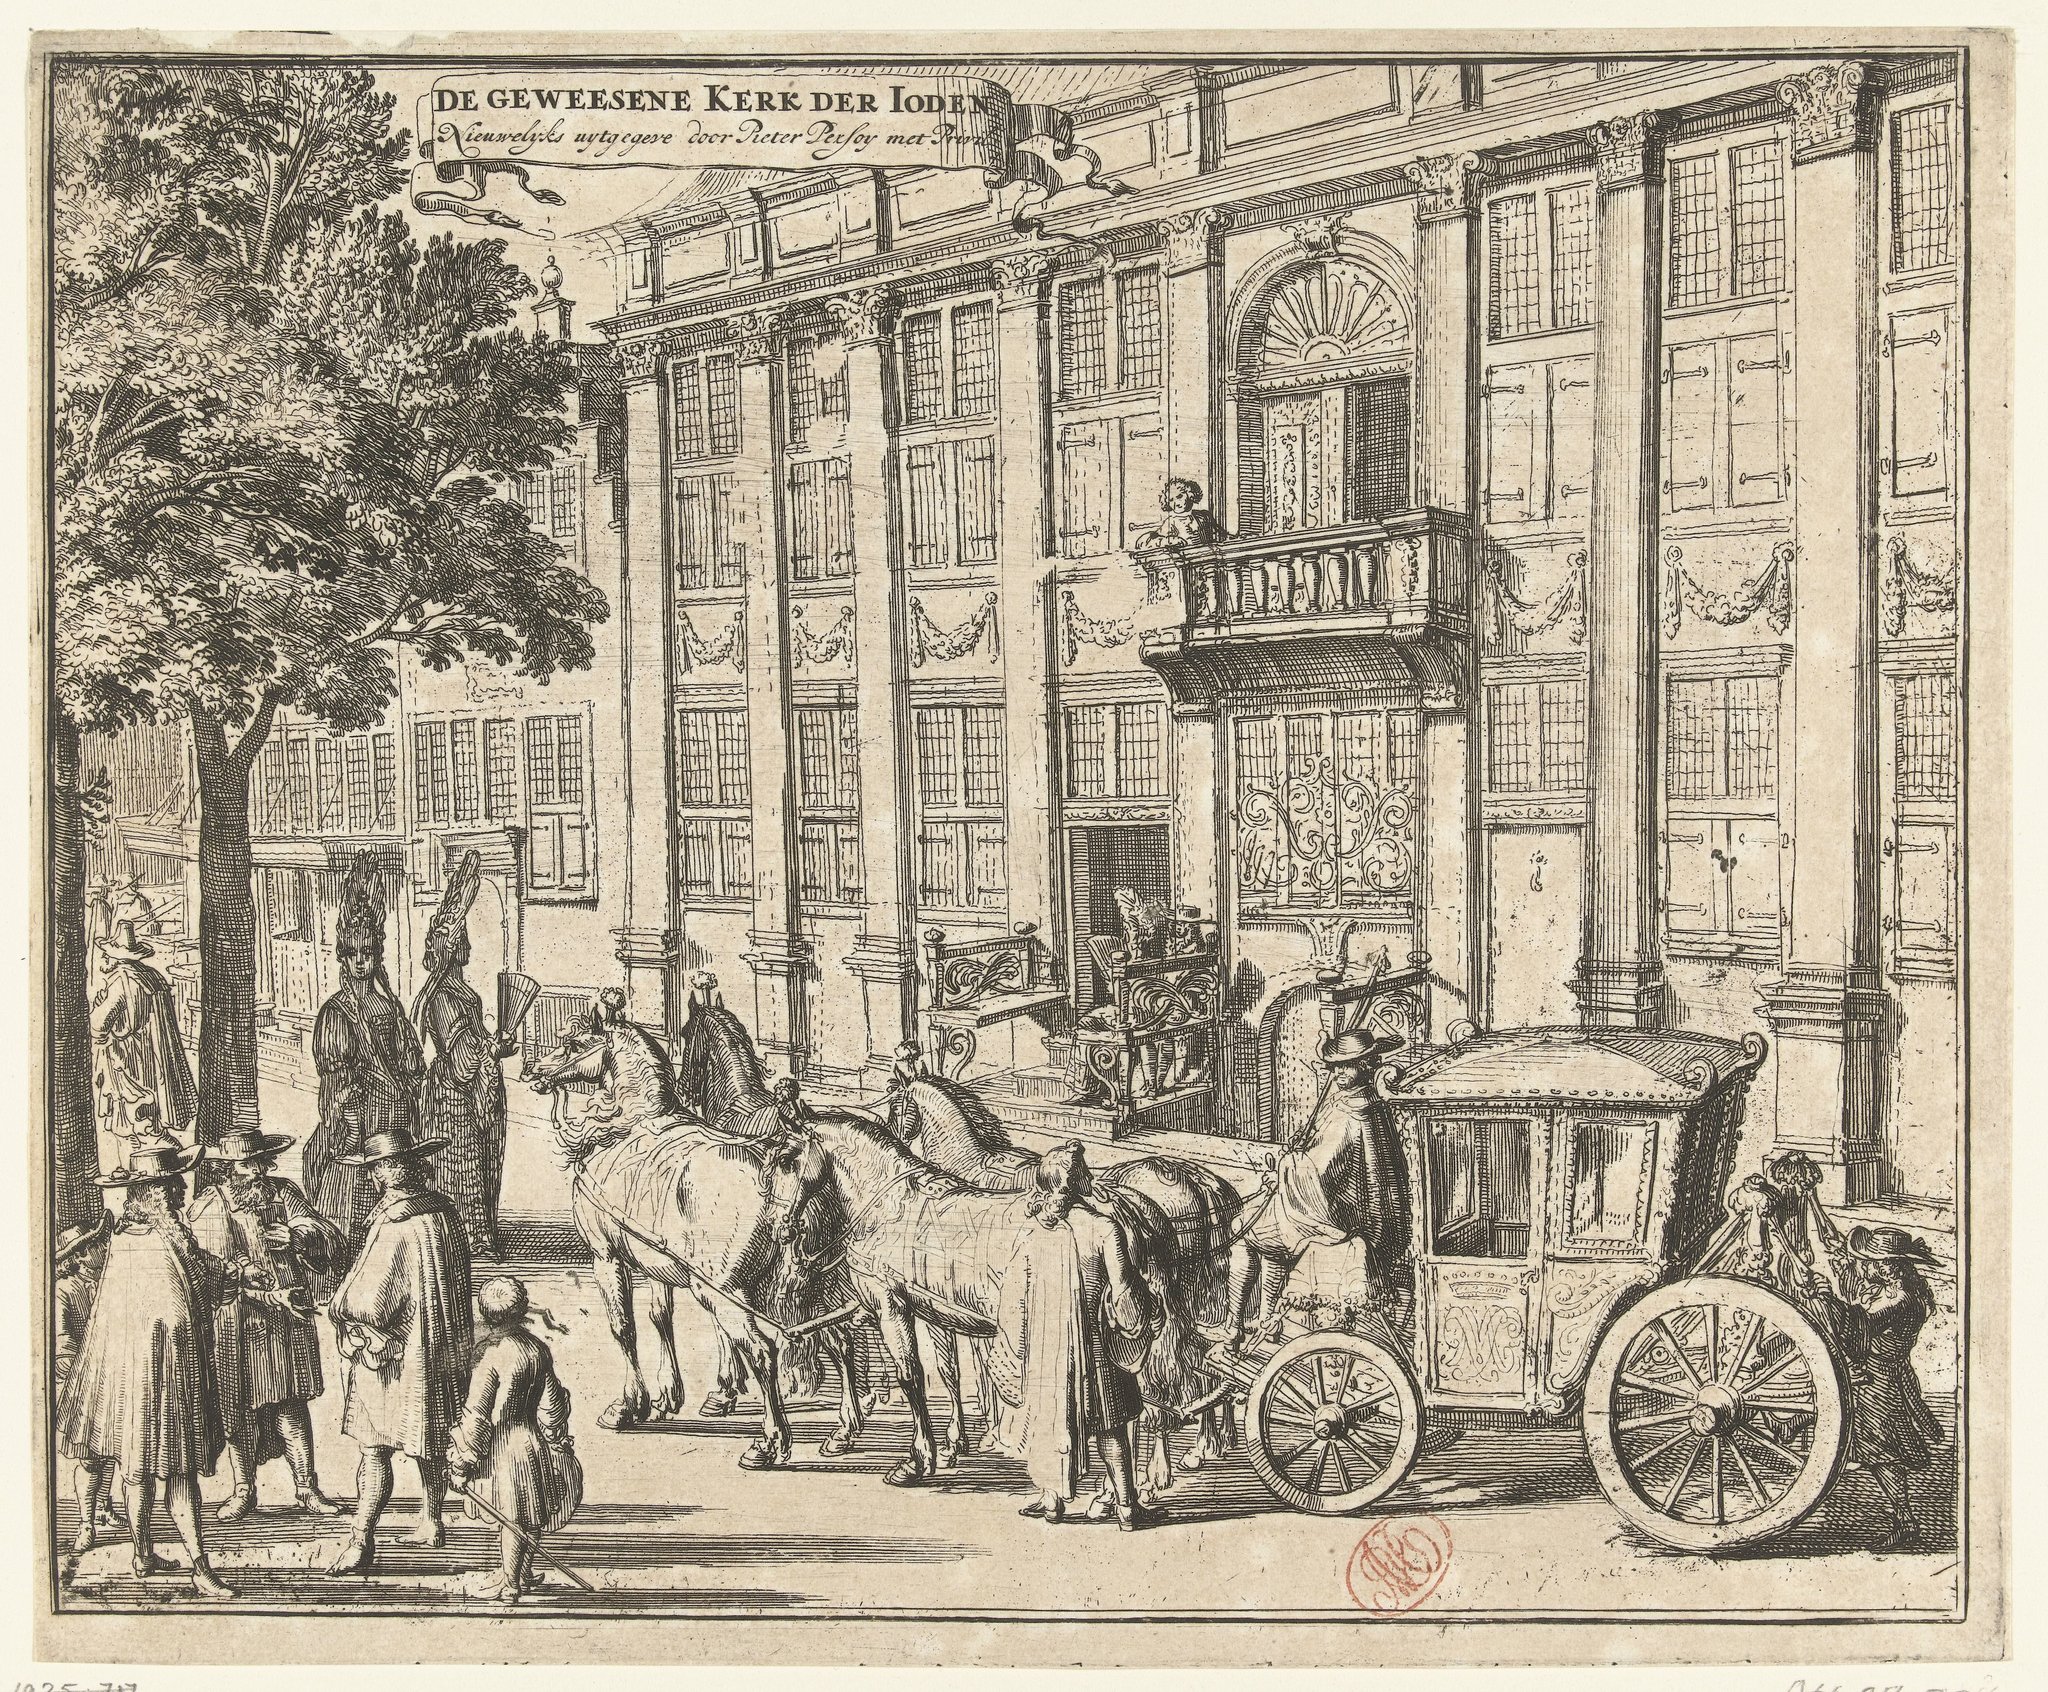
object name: print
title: De geweesene Kerk der Ioden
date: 1695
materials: paper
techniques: engraving, etching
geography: northern netherlands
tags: 'sephardim' ~ jewish communities, the synagogue (as building and place of worship ~ jewish religion), four-wheeled vehicle drawn by more than three animals, street (+ city(-scape) with figures, staffage)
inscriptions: collector's mark: Lugt 195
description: Mogelijk uitgegeven als onderdeel van een serie, zie RP-P-AO-8-16A, RP-P-AO-24-43-1, RP-P-AO-8-16B, RP-P-AO-24-43-2, RP-P-AO-24-26, RP-P-1908-178, RP-P-AO-24-30-1, RP-P-AO-24-30-2, RP-P-AO-24-31-1, RP-P-AO-24-31-2, RP-P-AO-24-74-1, RP-P-OB-5626, RP-P-AO-24-74-2, RP-P-OB-5625, RP-P-AO-24-75, RP-P-OB-5627 en RP-P-OB-67.742